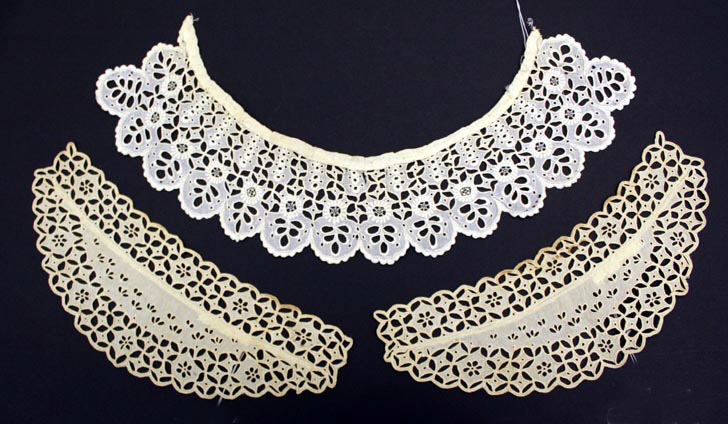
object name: accessory set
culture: american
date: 1840-1849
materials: cotton